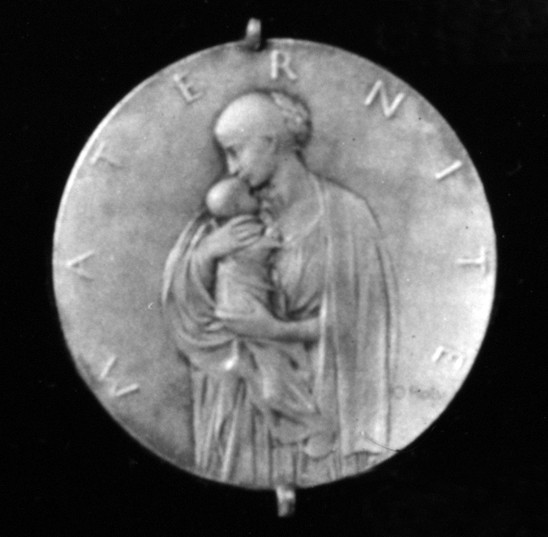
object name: jeton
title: Memorial of Baptism of the Artist's Son, Jean Georges Emile Roty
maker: louis-oscar roty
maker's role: artist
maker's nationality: french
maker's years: 1846-1911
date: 1893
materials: bronze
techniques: silvered, struck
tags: infants,mothers